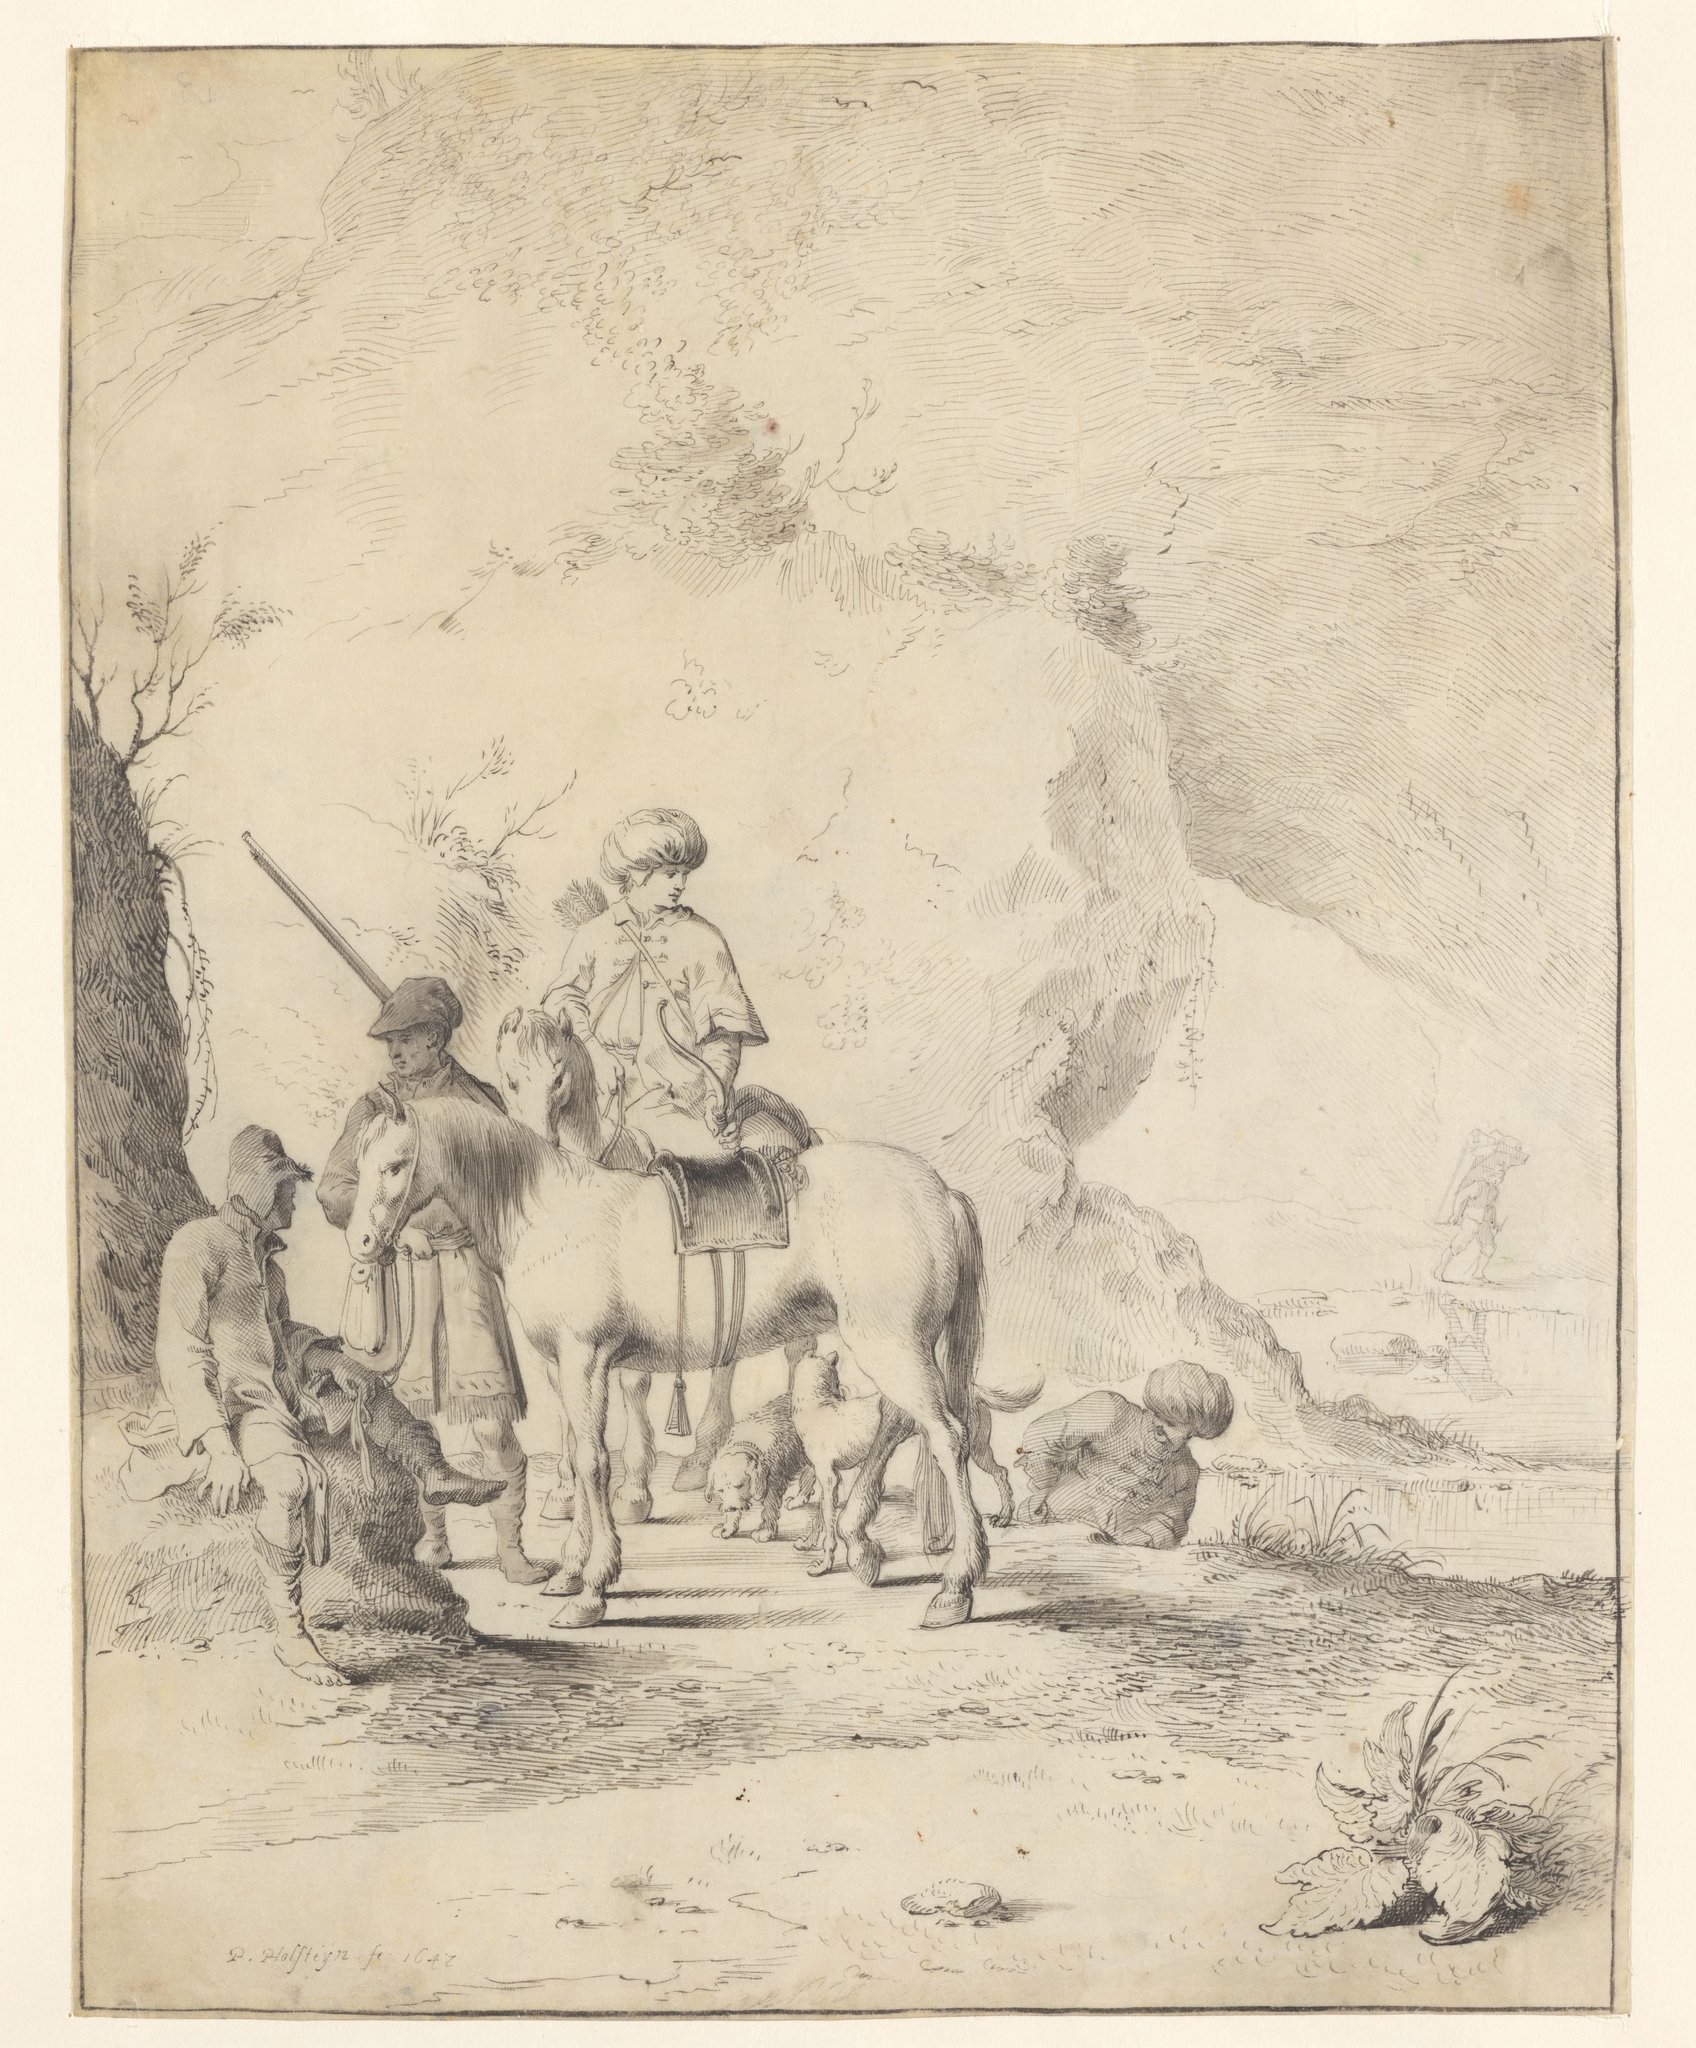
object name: drawing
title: Rustende jagers in berglandschap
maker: pieter holsteyn (ii)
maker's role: draughtsman, print maker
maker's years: 1614-1673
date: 1647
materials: ink, parchment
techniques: pen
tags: hunting, chase